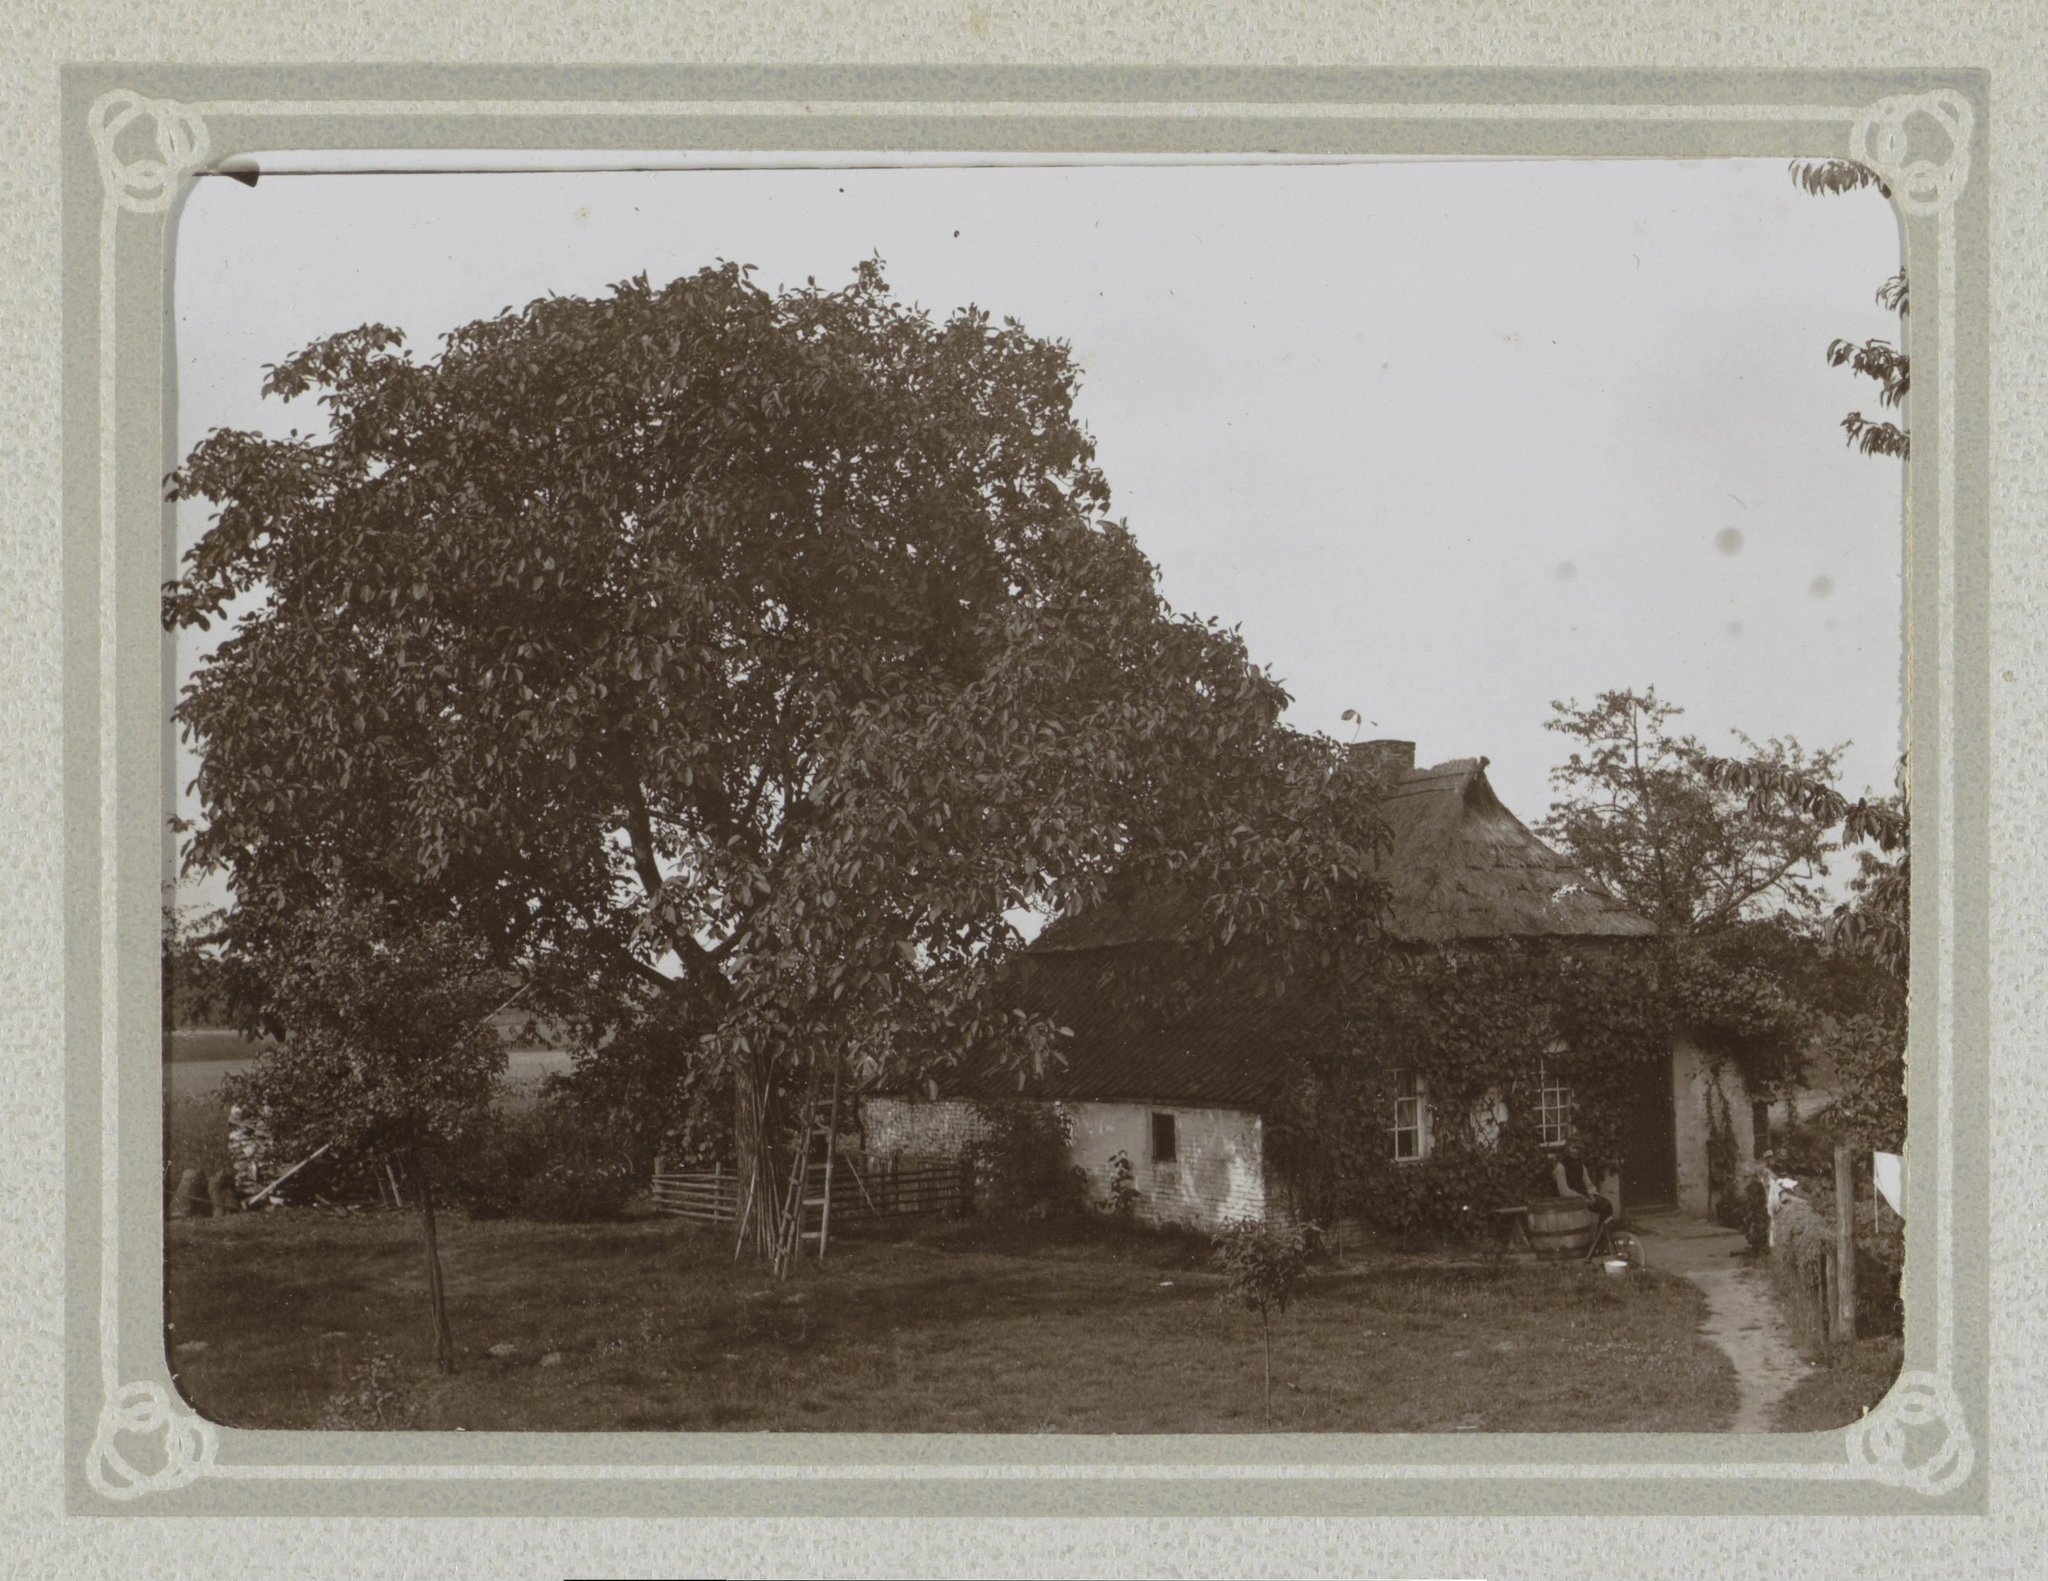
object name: photograph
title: Boerderij naast een hoge boom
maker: folkert idzes de jong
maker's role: architect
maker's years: 1877-1929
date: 1905-1907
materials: photographic support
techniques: collodion silver print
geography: netherlands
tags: trees, farm (building), netherlands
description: Onderdeel van Topografisch album van Nederlandse dorpen en steden 1905.